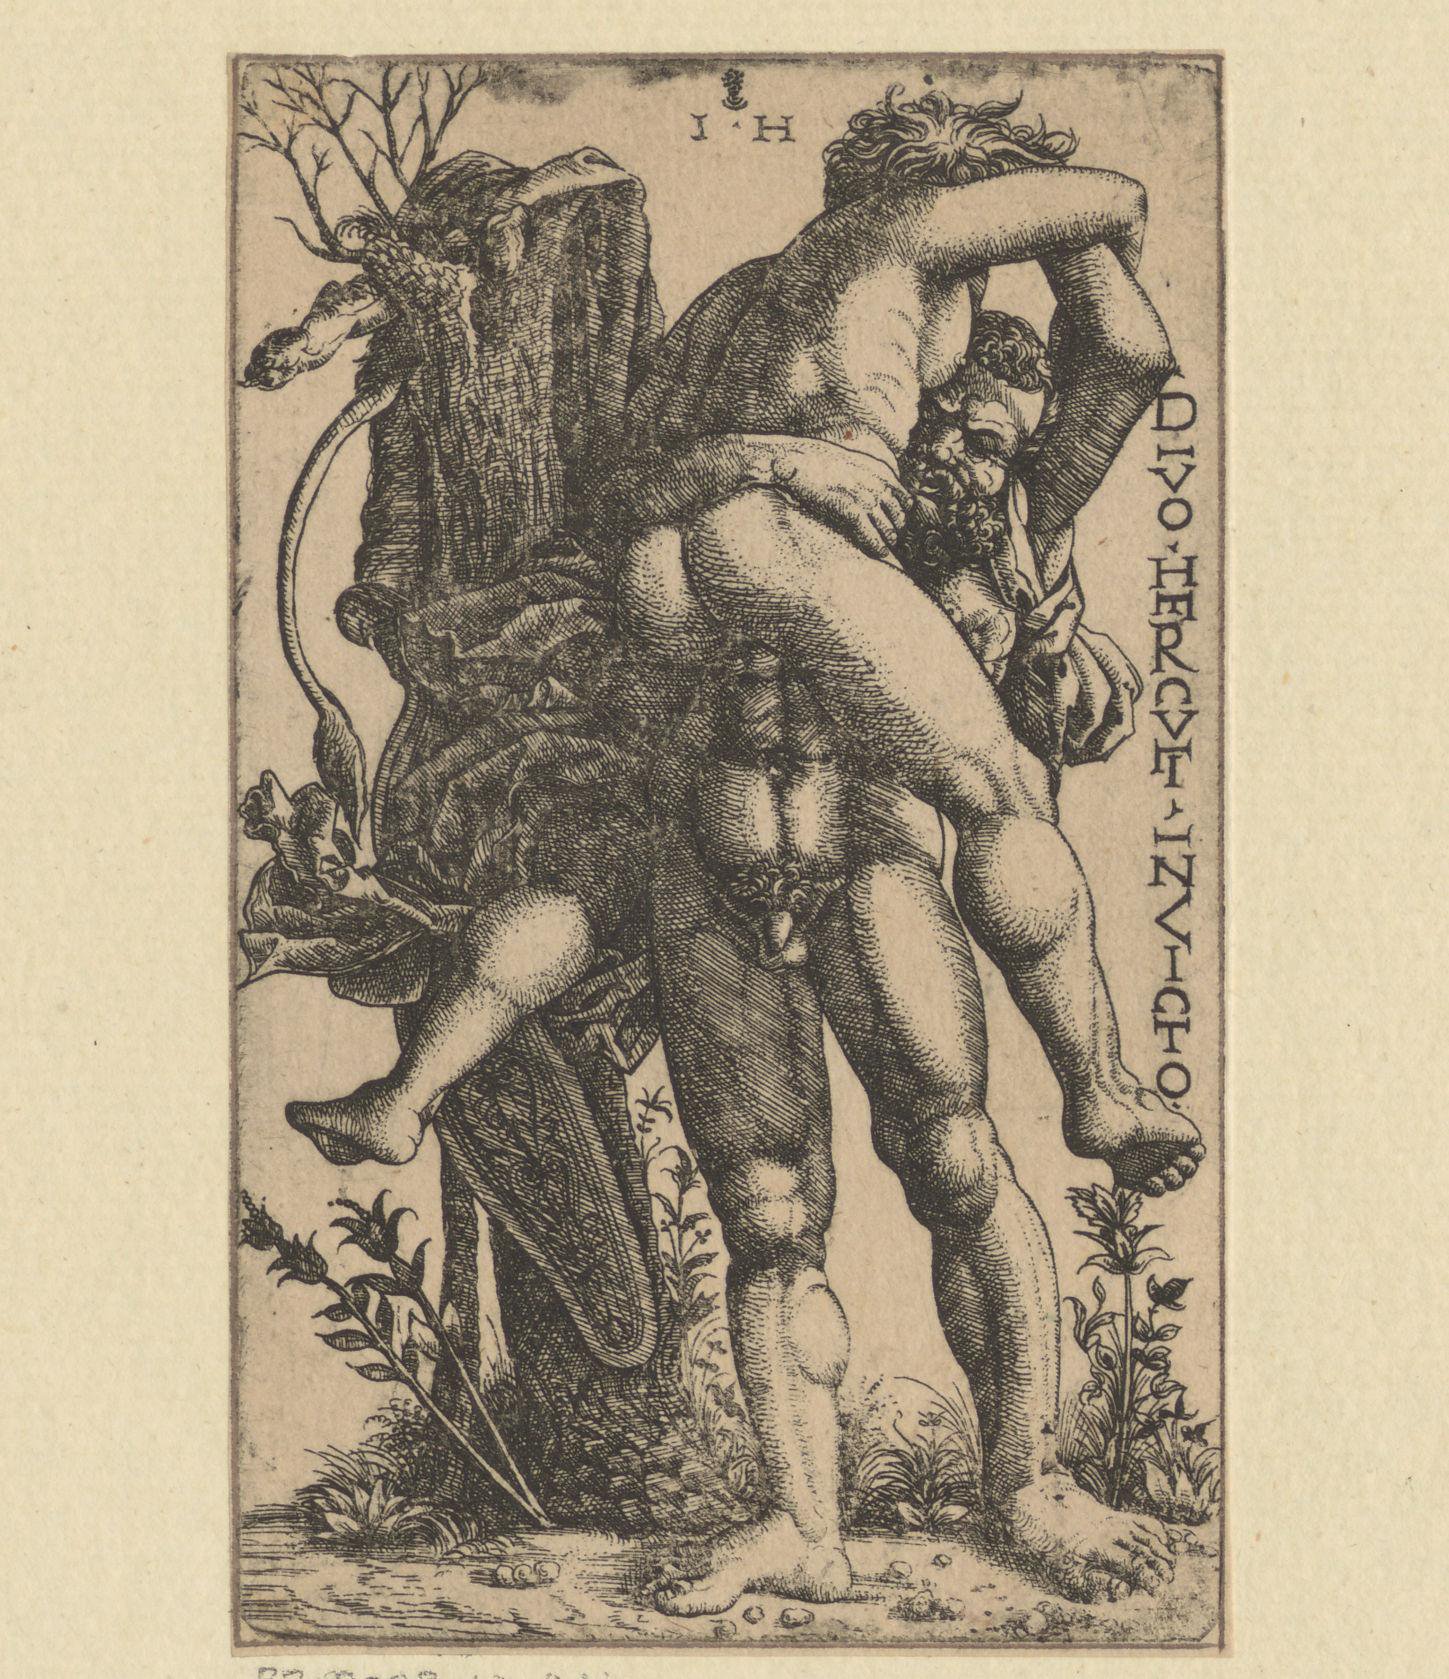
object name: print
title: Hercules en Antaeus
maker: hieronymus hopfer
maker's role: print maker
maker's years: 1500-1550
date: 1525-1550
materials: paper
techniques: etching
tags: the giant antaeus is lifted in the air and crushed to death by hercules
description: Deze prent is een kopie naar de gravure door Andrea Mantegna, aanwezig in de collectie van het RMA: RP-P-OB-1963, RP-P-OB-1964, en RP-P-H-A-11.